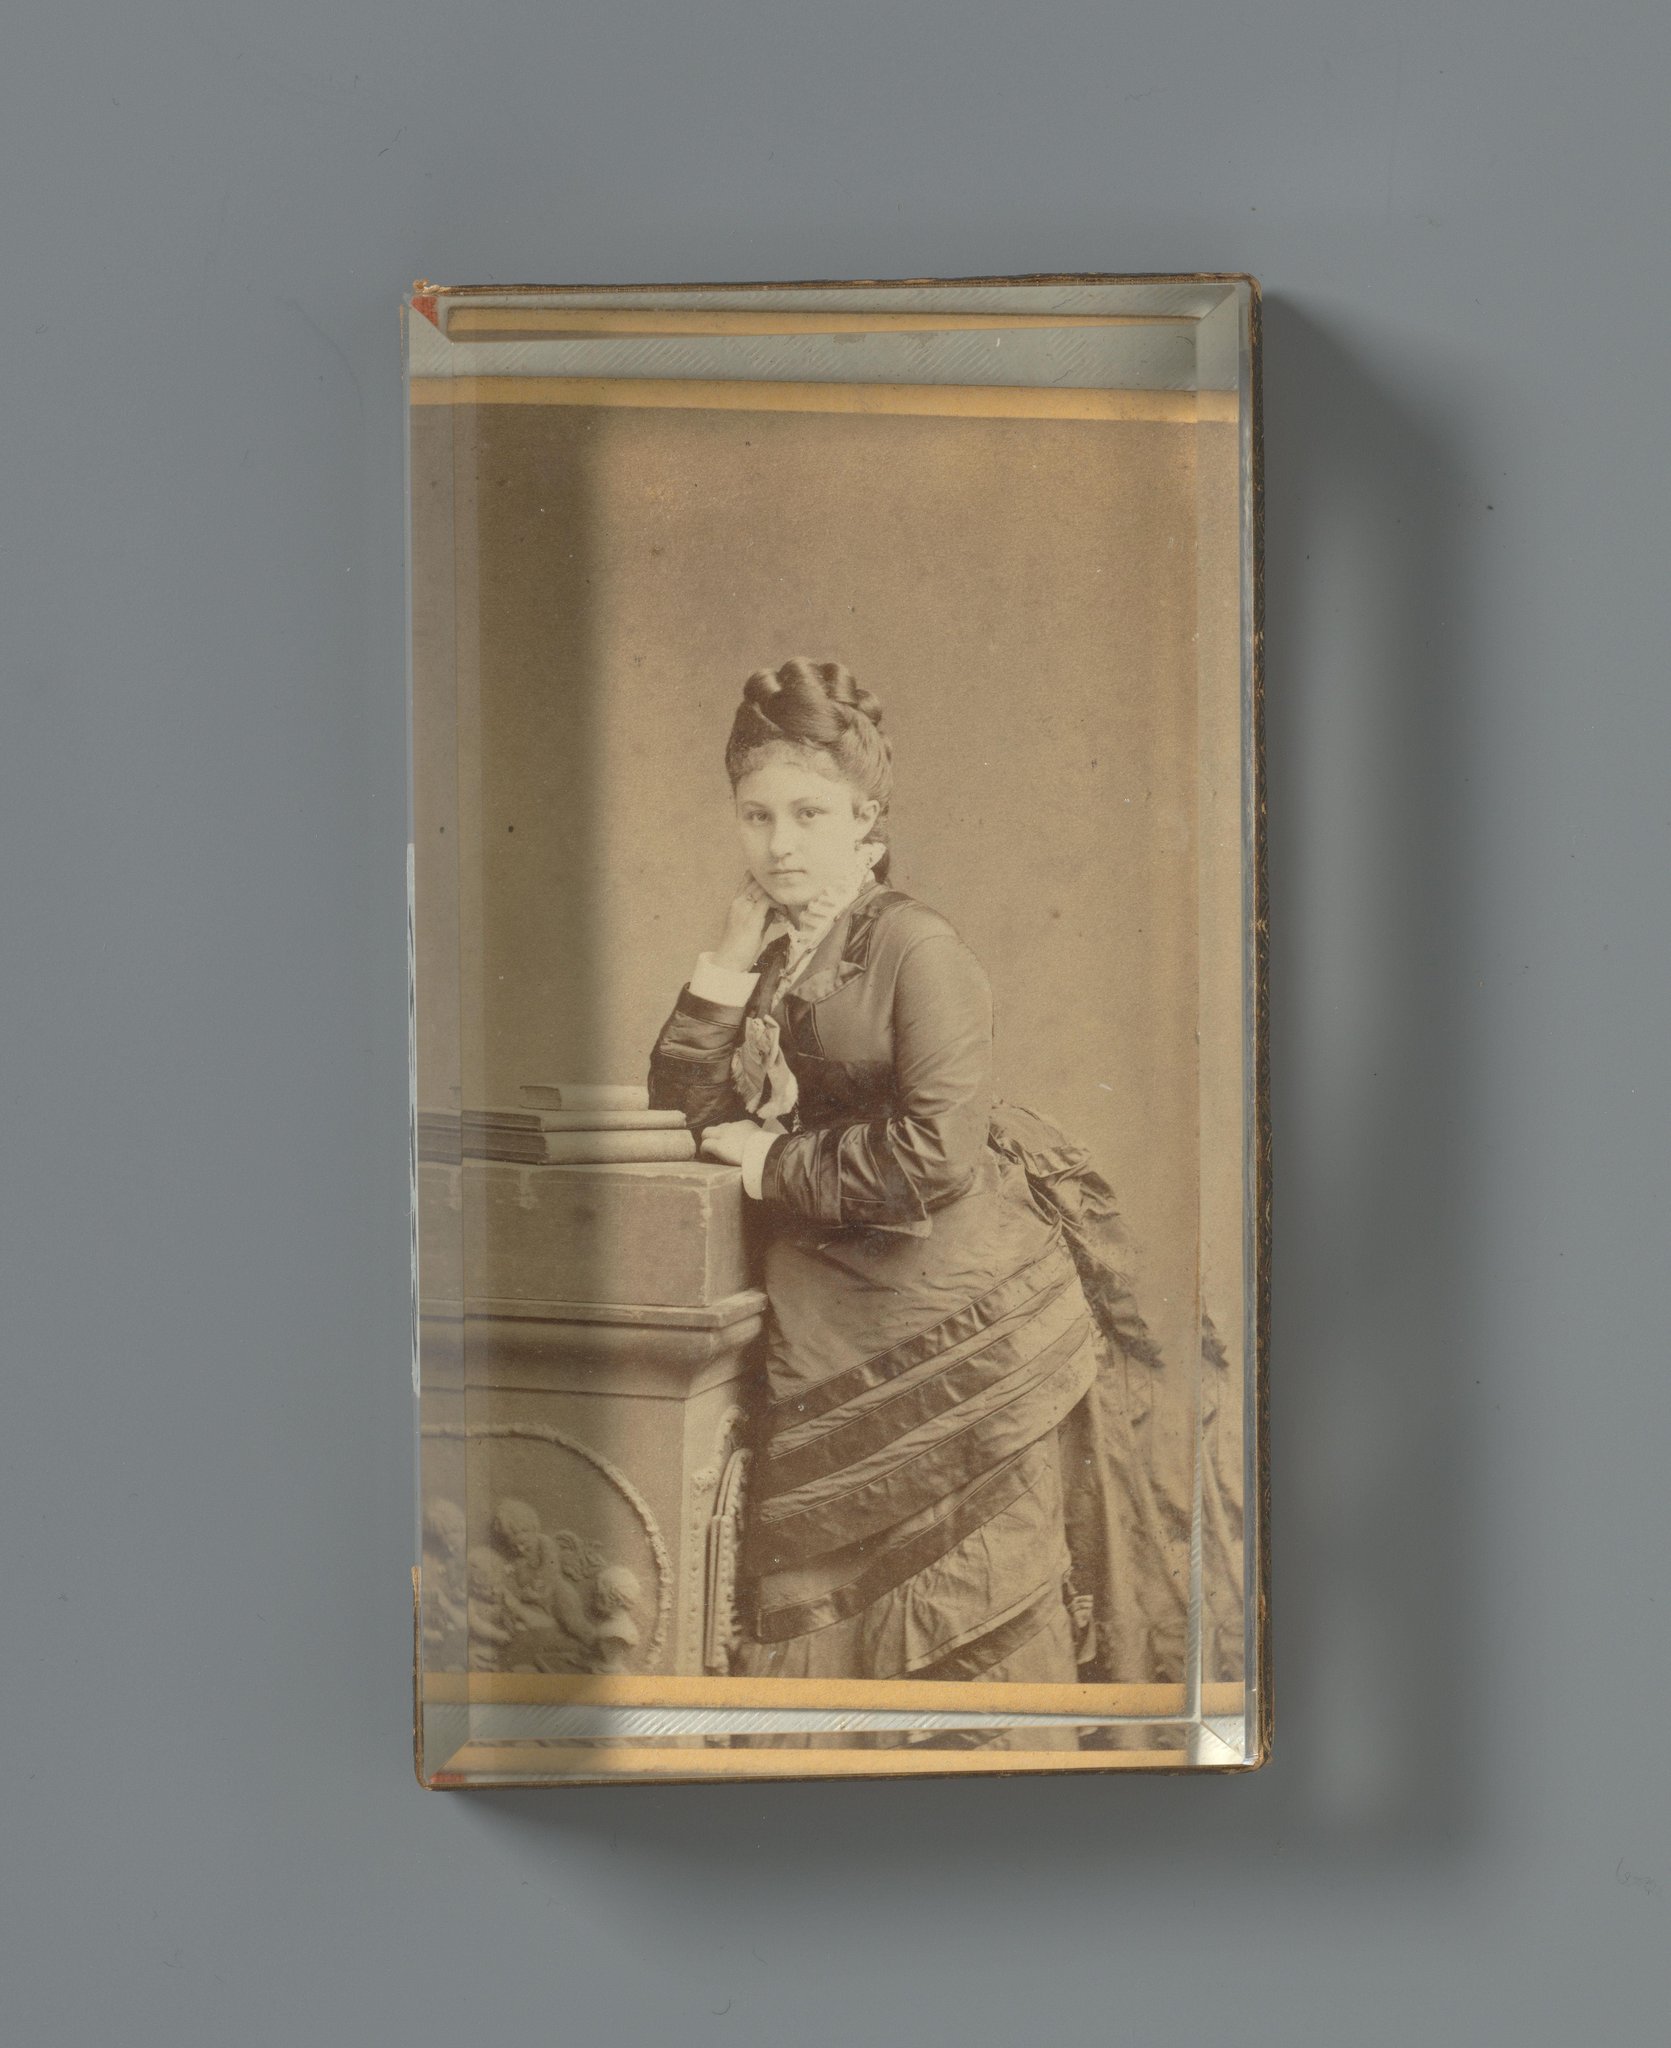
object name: carte de visite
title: Presse-papier met portret van een onbekende vrouw leunend tegen een zuil met boeken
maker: Anonymous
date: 1857-1885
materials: cardboard, glass, paper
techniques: albumen print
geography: java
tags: historical persons not known by name - bb - woman, java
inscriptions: inscription: ‘Woodbury & Page/, Photographers/ Java’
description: Rechthoekige glazen presse-papier met daarin een carte-de-visite van een onbekende vrouw leunend tegen een zuil met boeken.